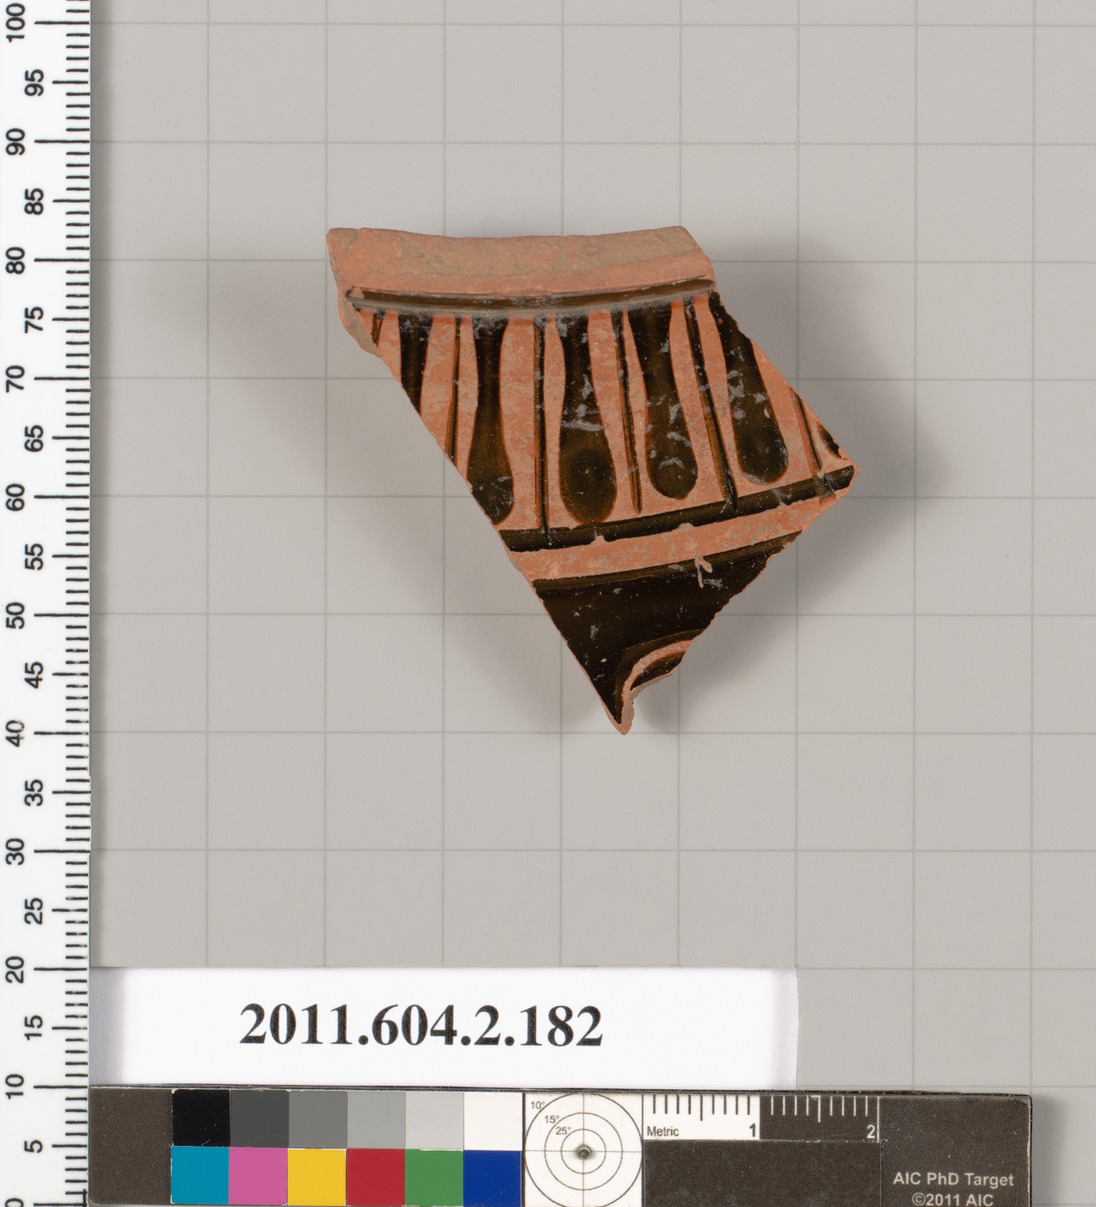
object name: stamnos fragment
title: Terracotta fragment of a stamnos (jar)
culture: greek, attic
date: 500-470 BCE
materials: terracotta